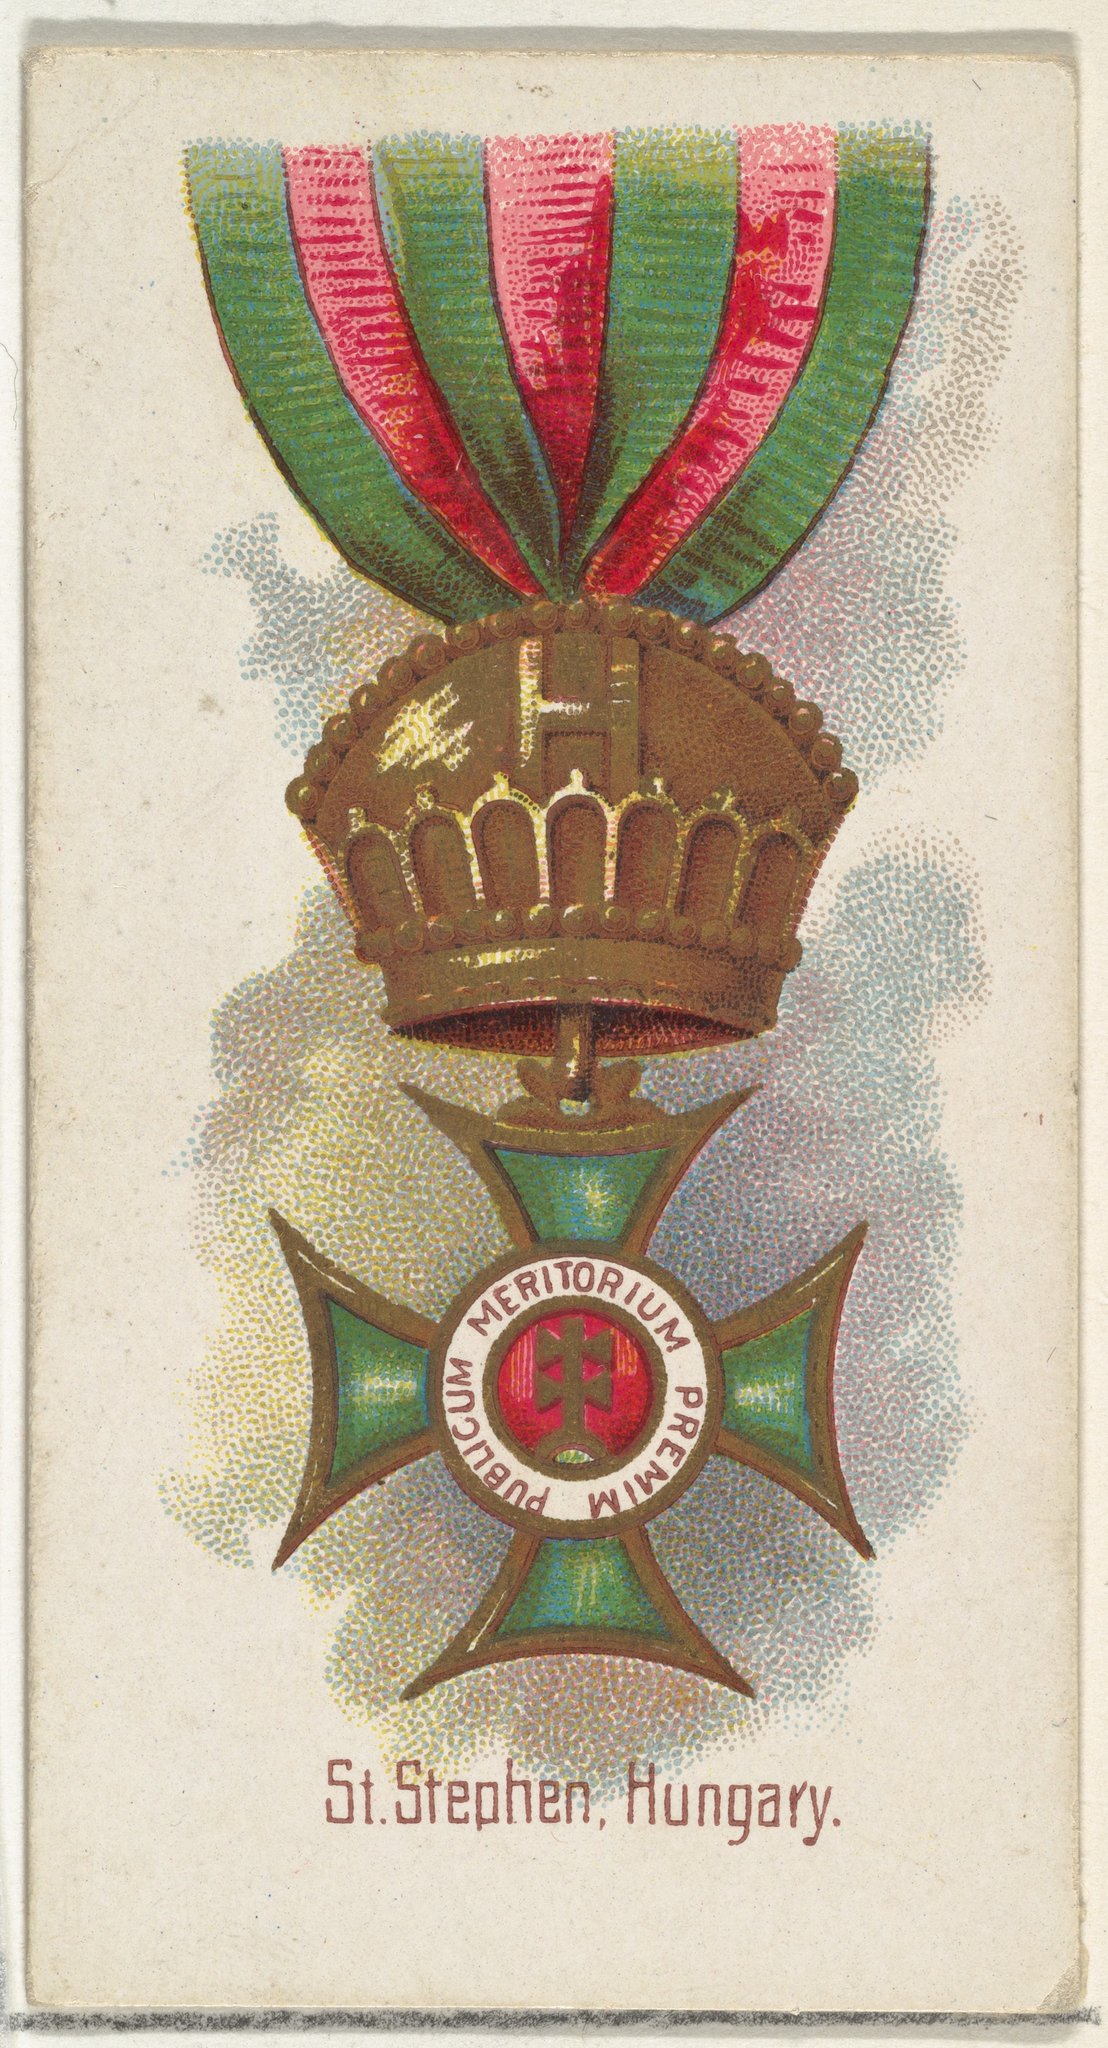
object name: print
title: St. Stephen, Hungary, from the World's Decorations series (N30) for Allen & Ginter Cigarettes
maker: allen & ginter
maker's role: publisher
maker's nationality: american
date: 1890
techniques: color lithograph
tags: medals